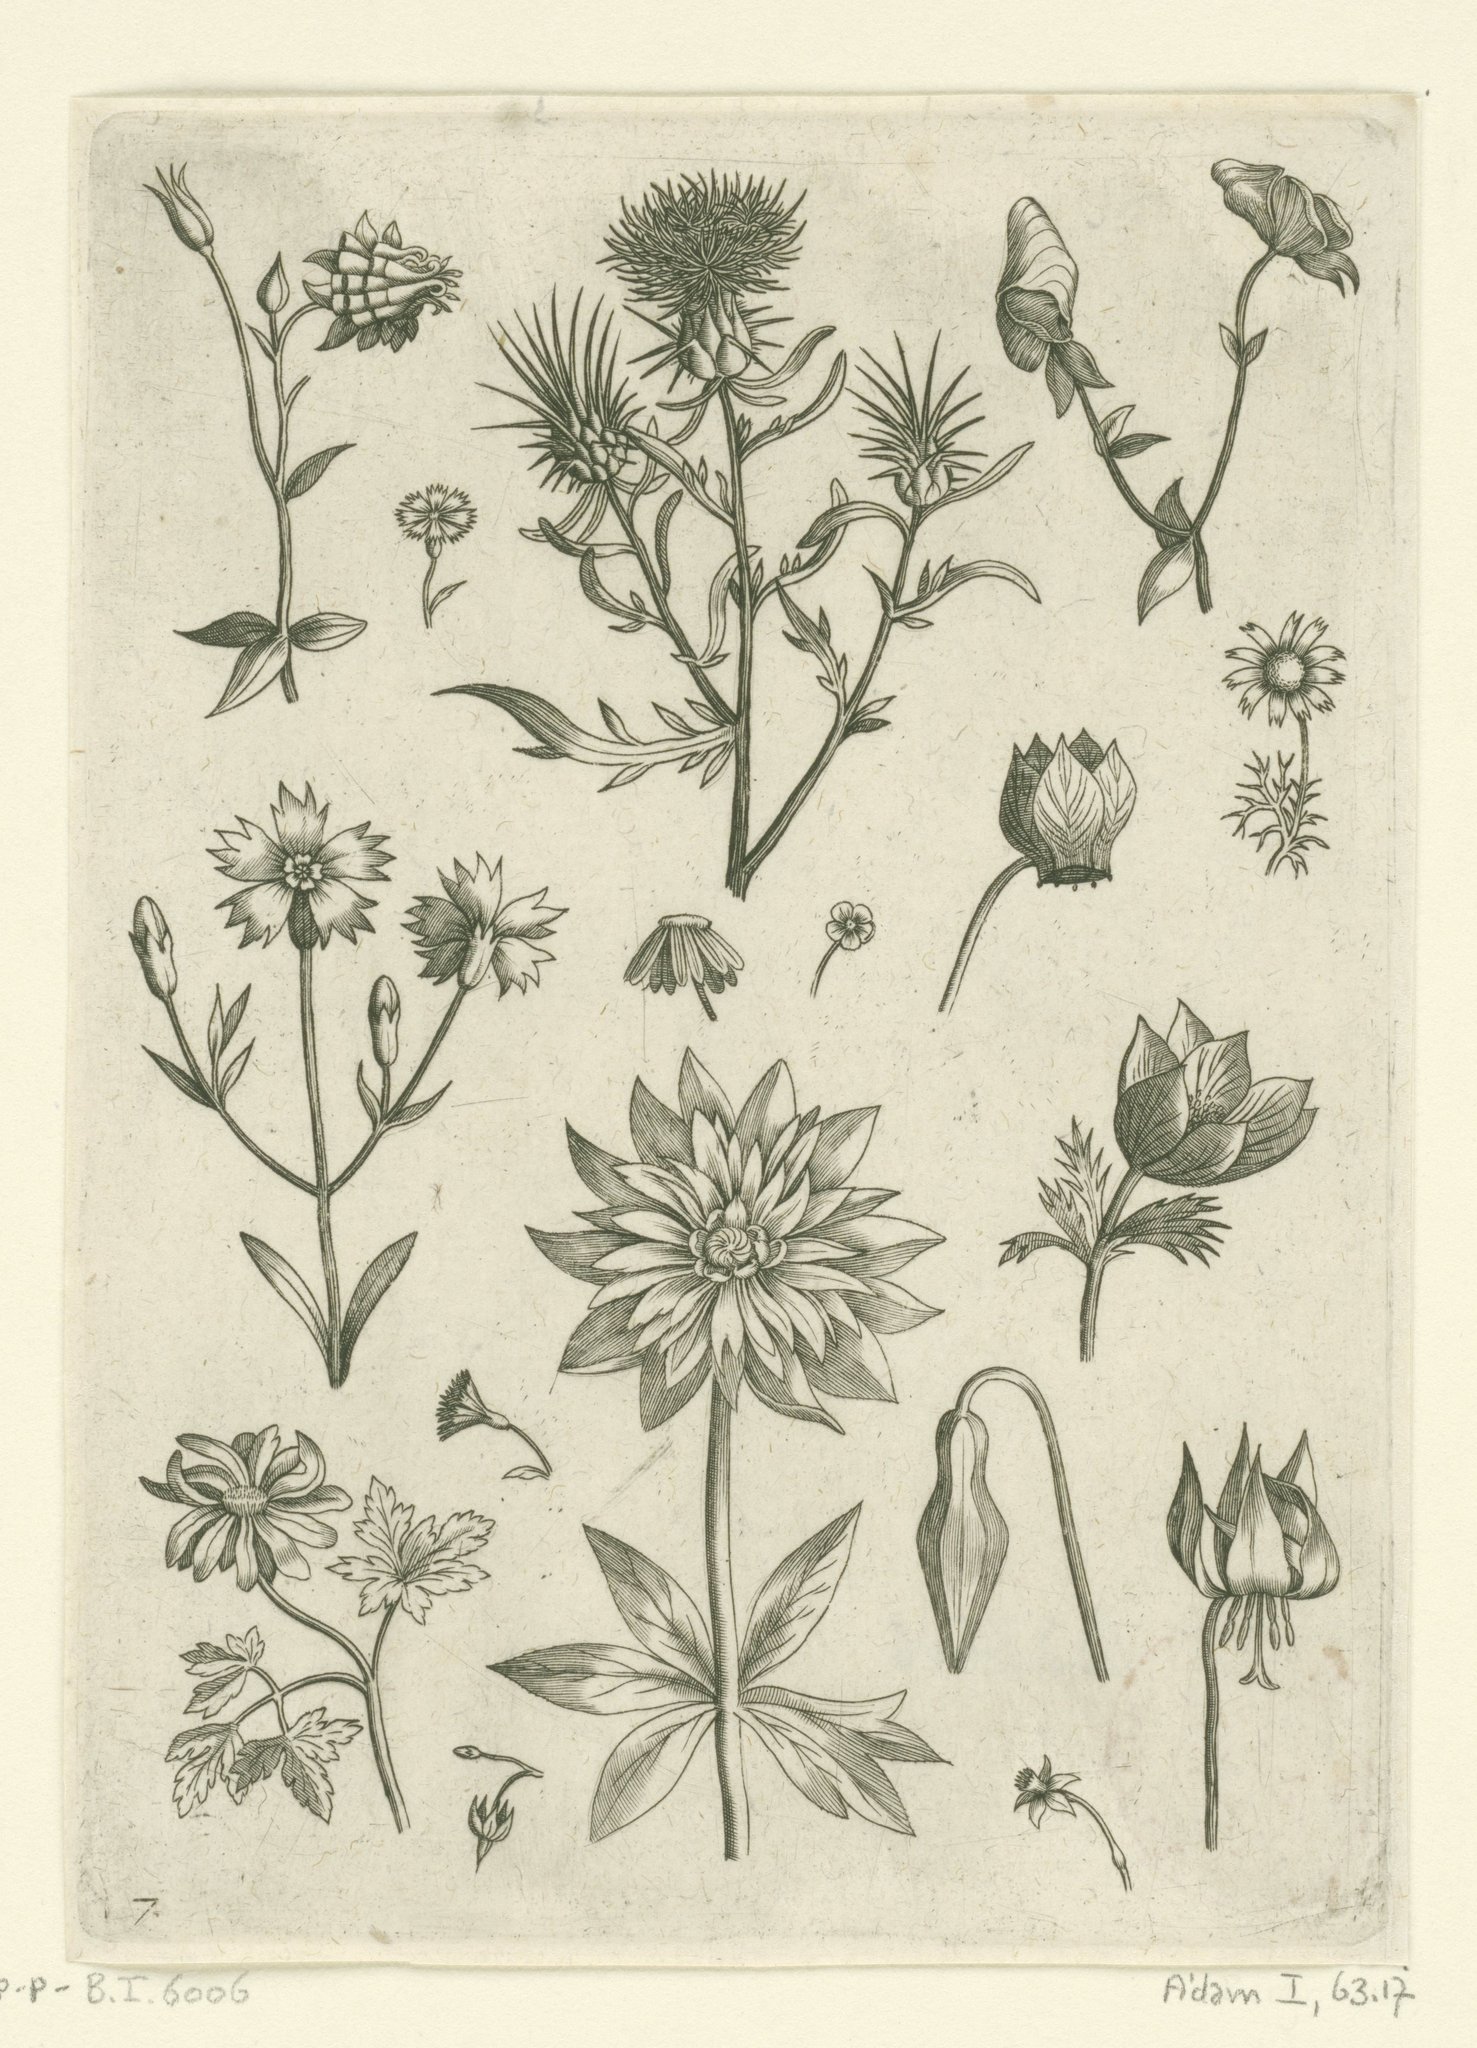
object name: print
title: Verschillende bloemen, waaronder akelei en cyclaam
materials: paper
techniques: engraving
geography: netherlands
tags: flowers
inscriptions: collector's mark: Lugt 240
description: Linksboven een akelei en rechtsonder een cyclaam. Blad 17 van 21 genummerde bladen met titelblad afkomstig uit een serie van 24.